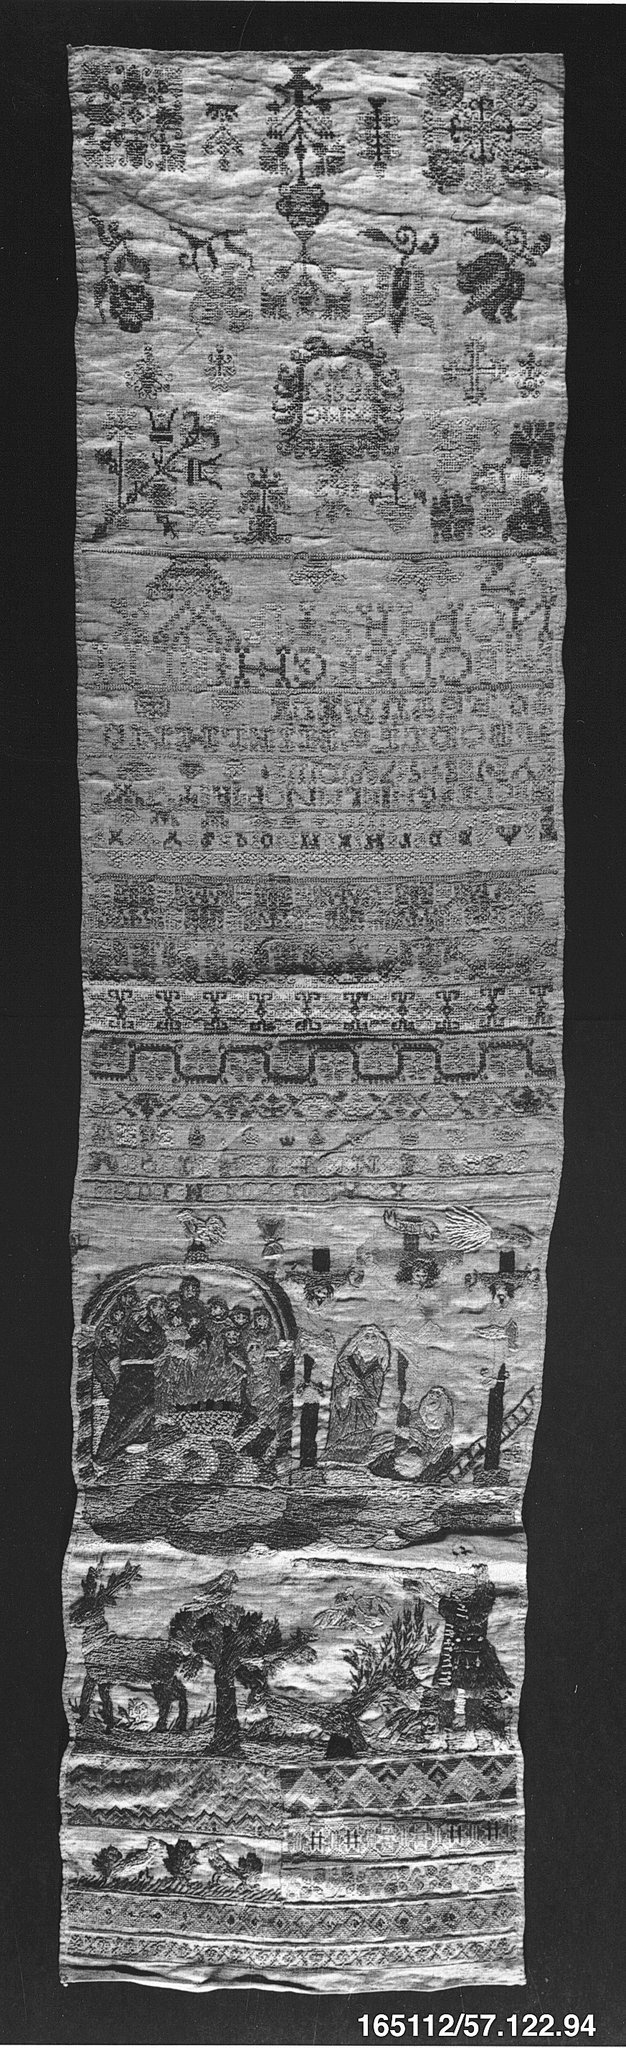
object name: sampler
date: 1747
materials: linen, metal thread, silk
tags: birds,men,deer